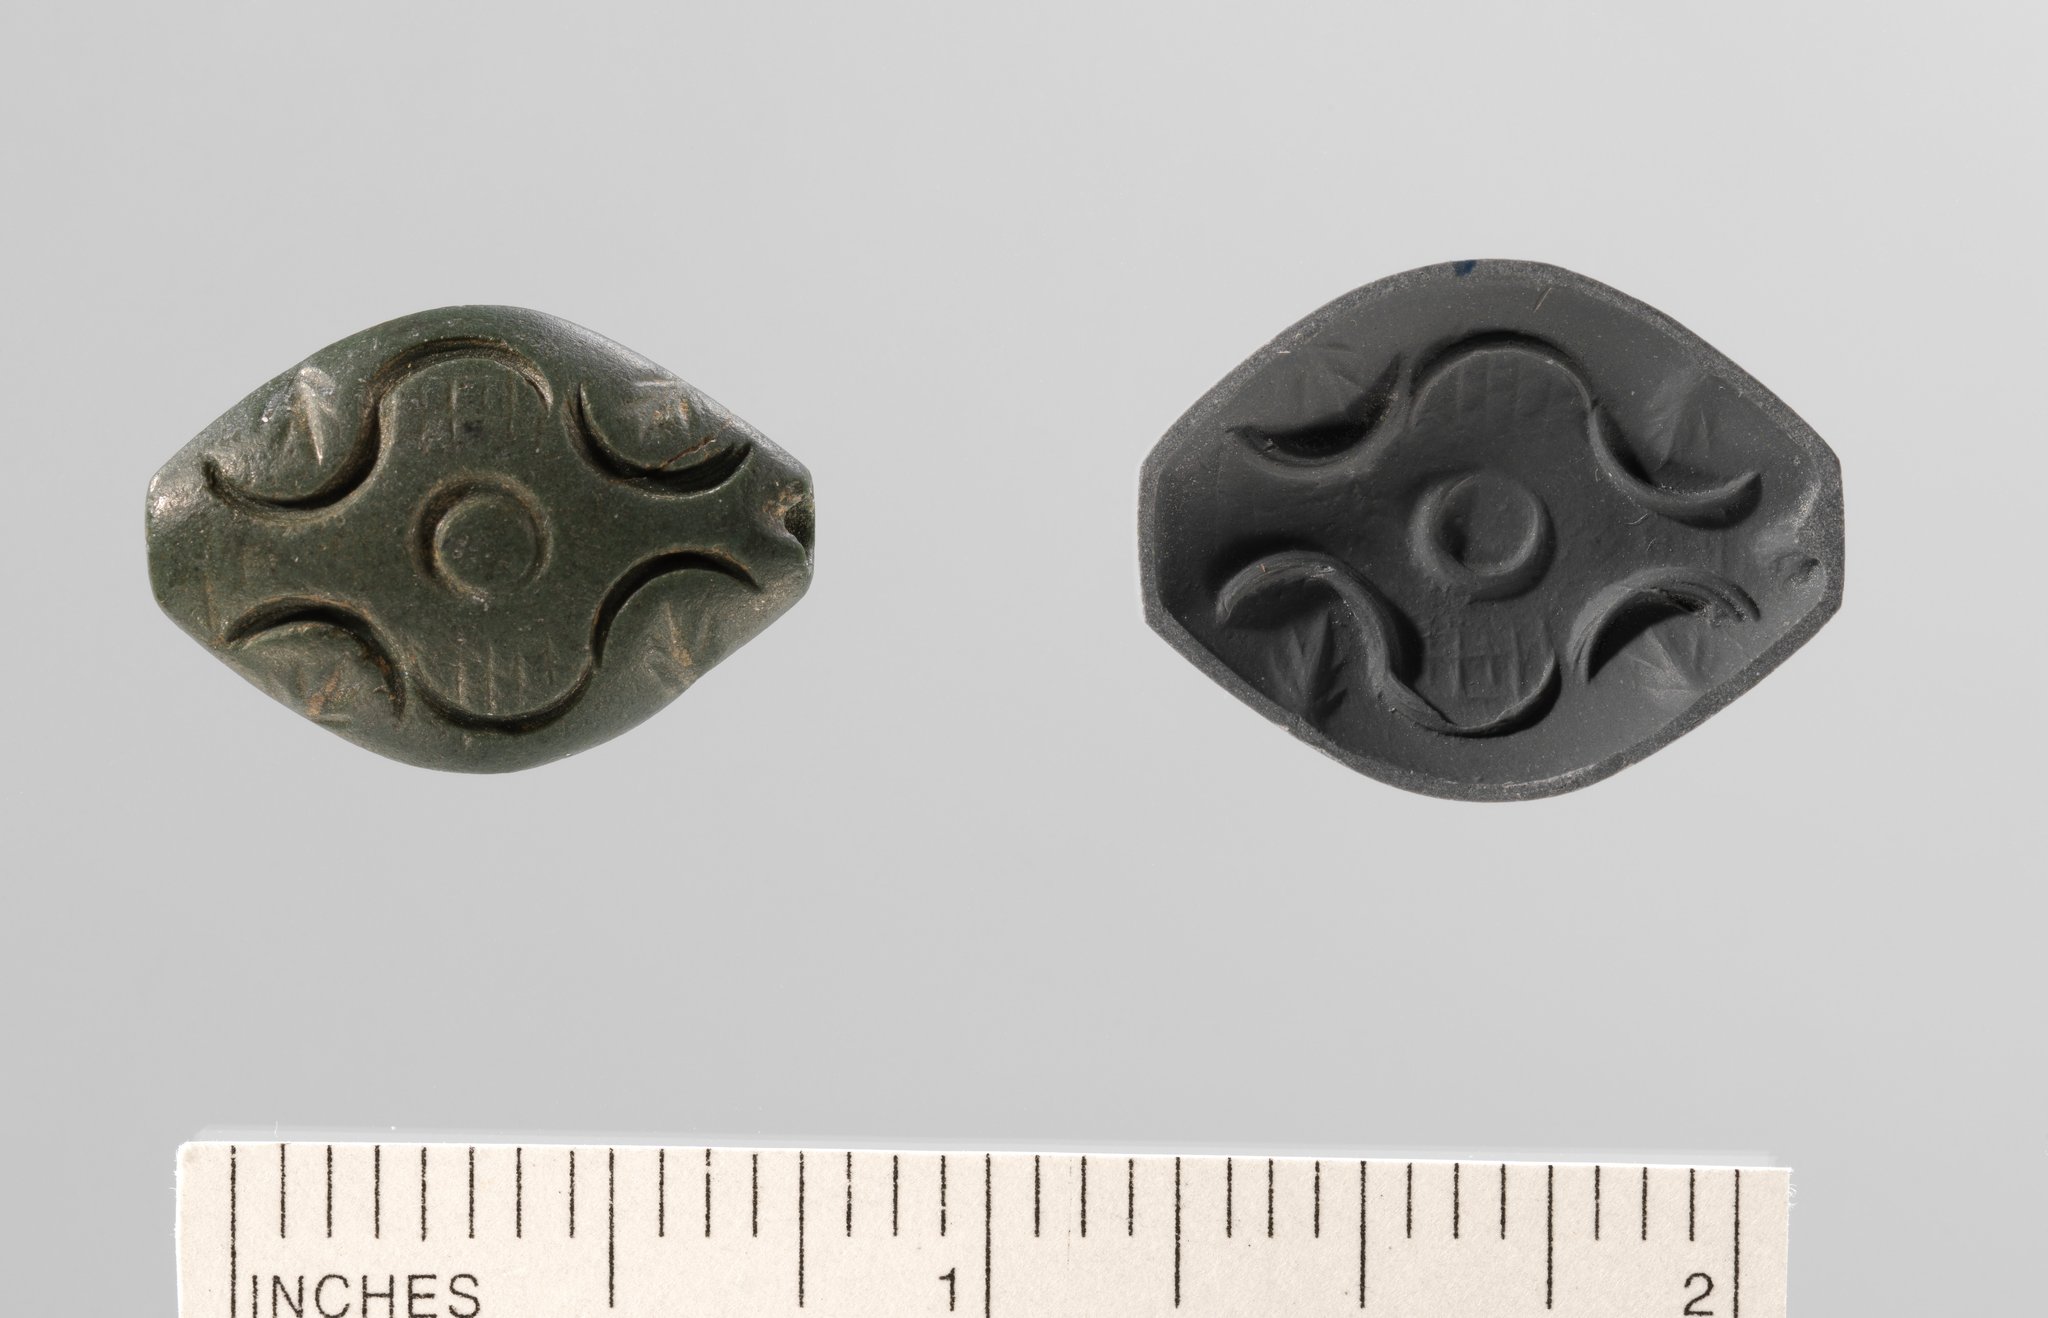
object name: seal, amygdaloid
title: Jasper Amygdaloid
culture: minoan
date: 1650-1500 BCE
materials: jasper